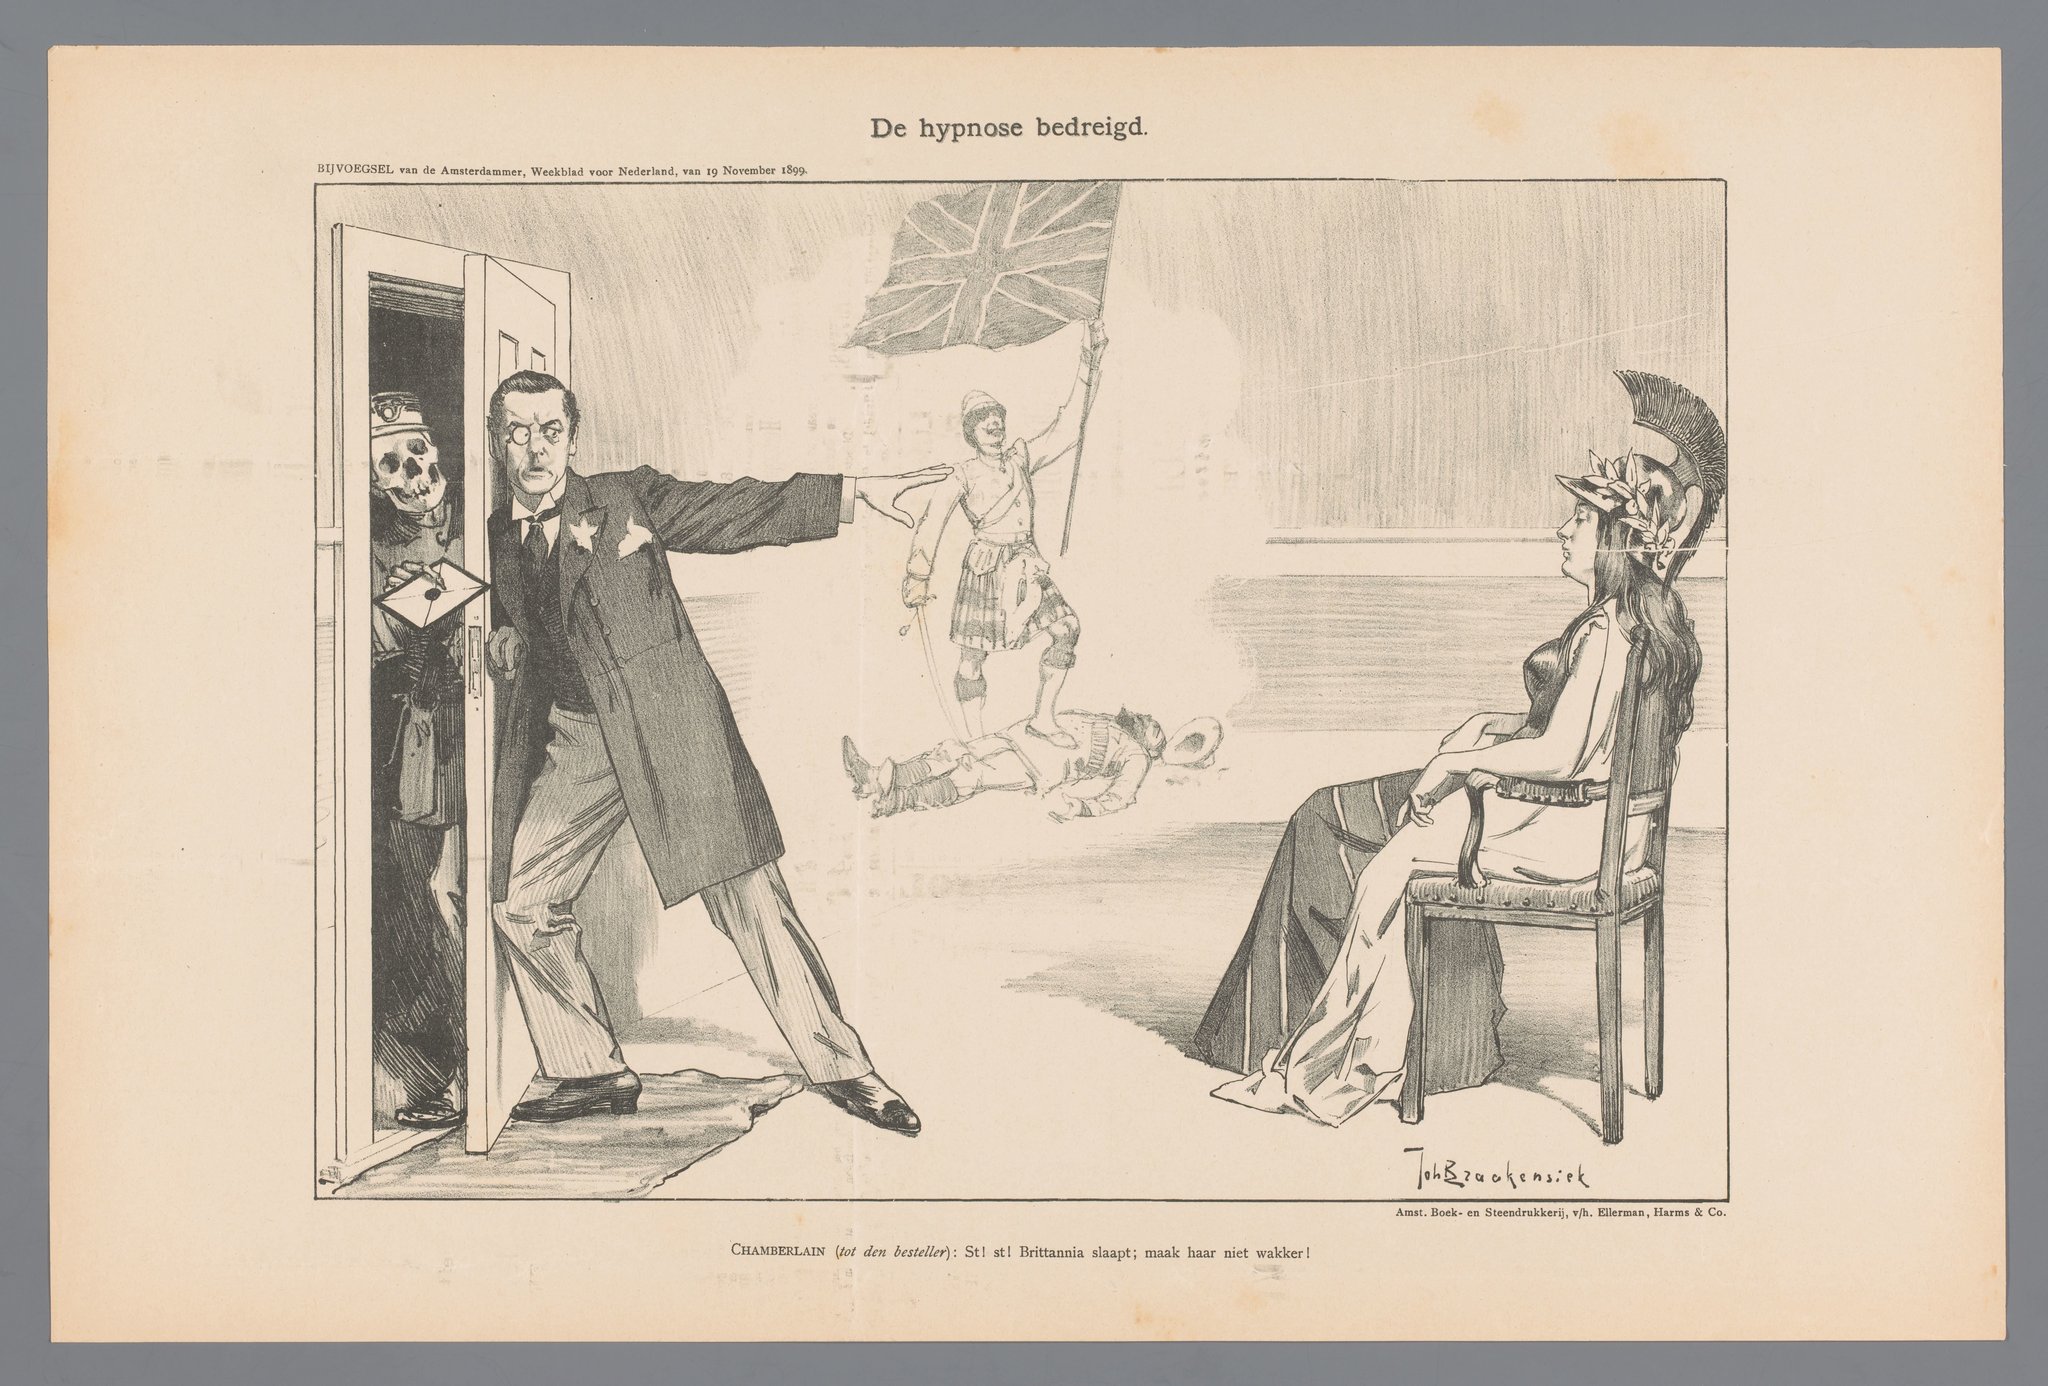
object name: cartoon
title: De hypnose bedreigd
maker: johan braakensiek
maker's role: draughtsman, print maker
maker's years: 1858-1940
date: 1899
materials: paper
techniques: lithograph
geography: amsterdam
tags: politician, personifications of countries, nations, states, districts, etc., hypnosis and suggestion, historical persons, political caricatures and satires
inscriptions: date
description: Prent uit het bijvoegsel van: De Amsterdammer. Weekblad voor Nederland, 19 november 1899.